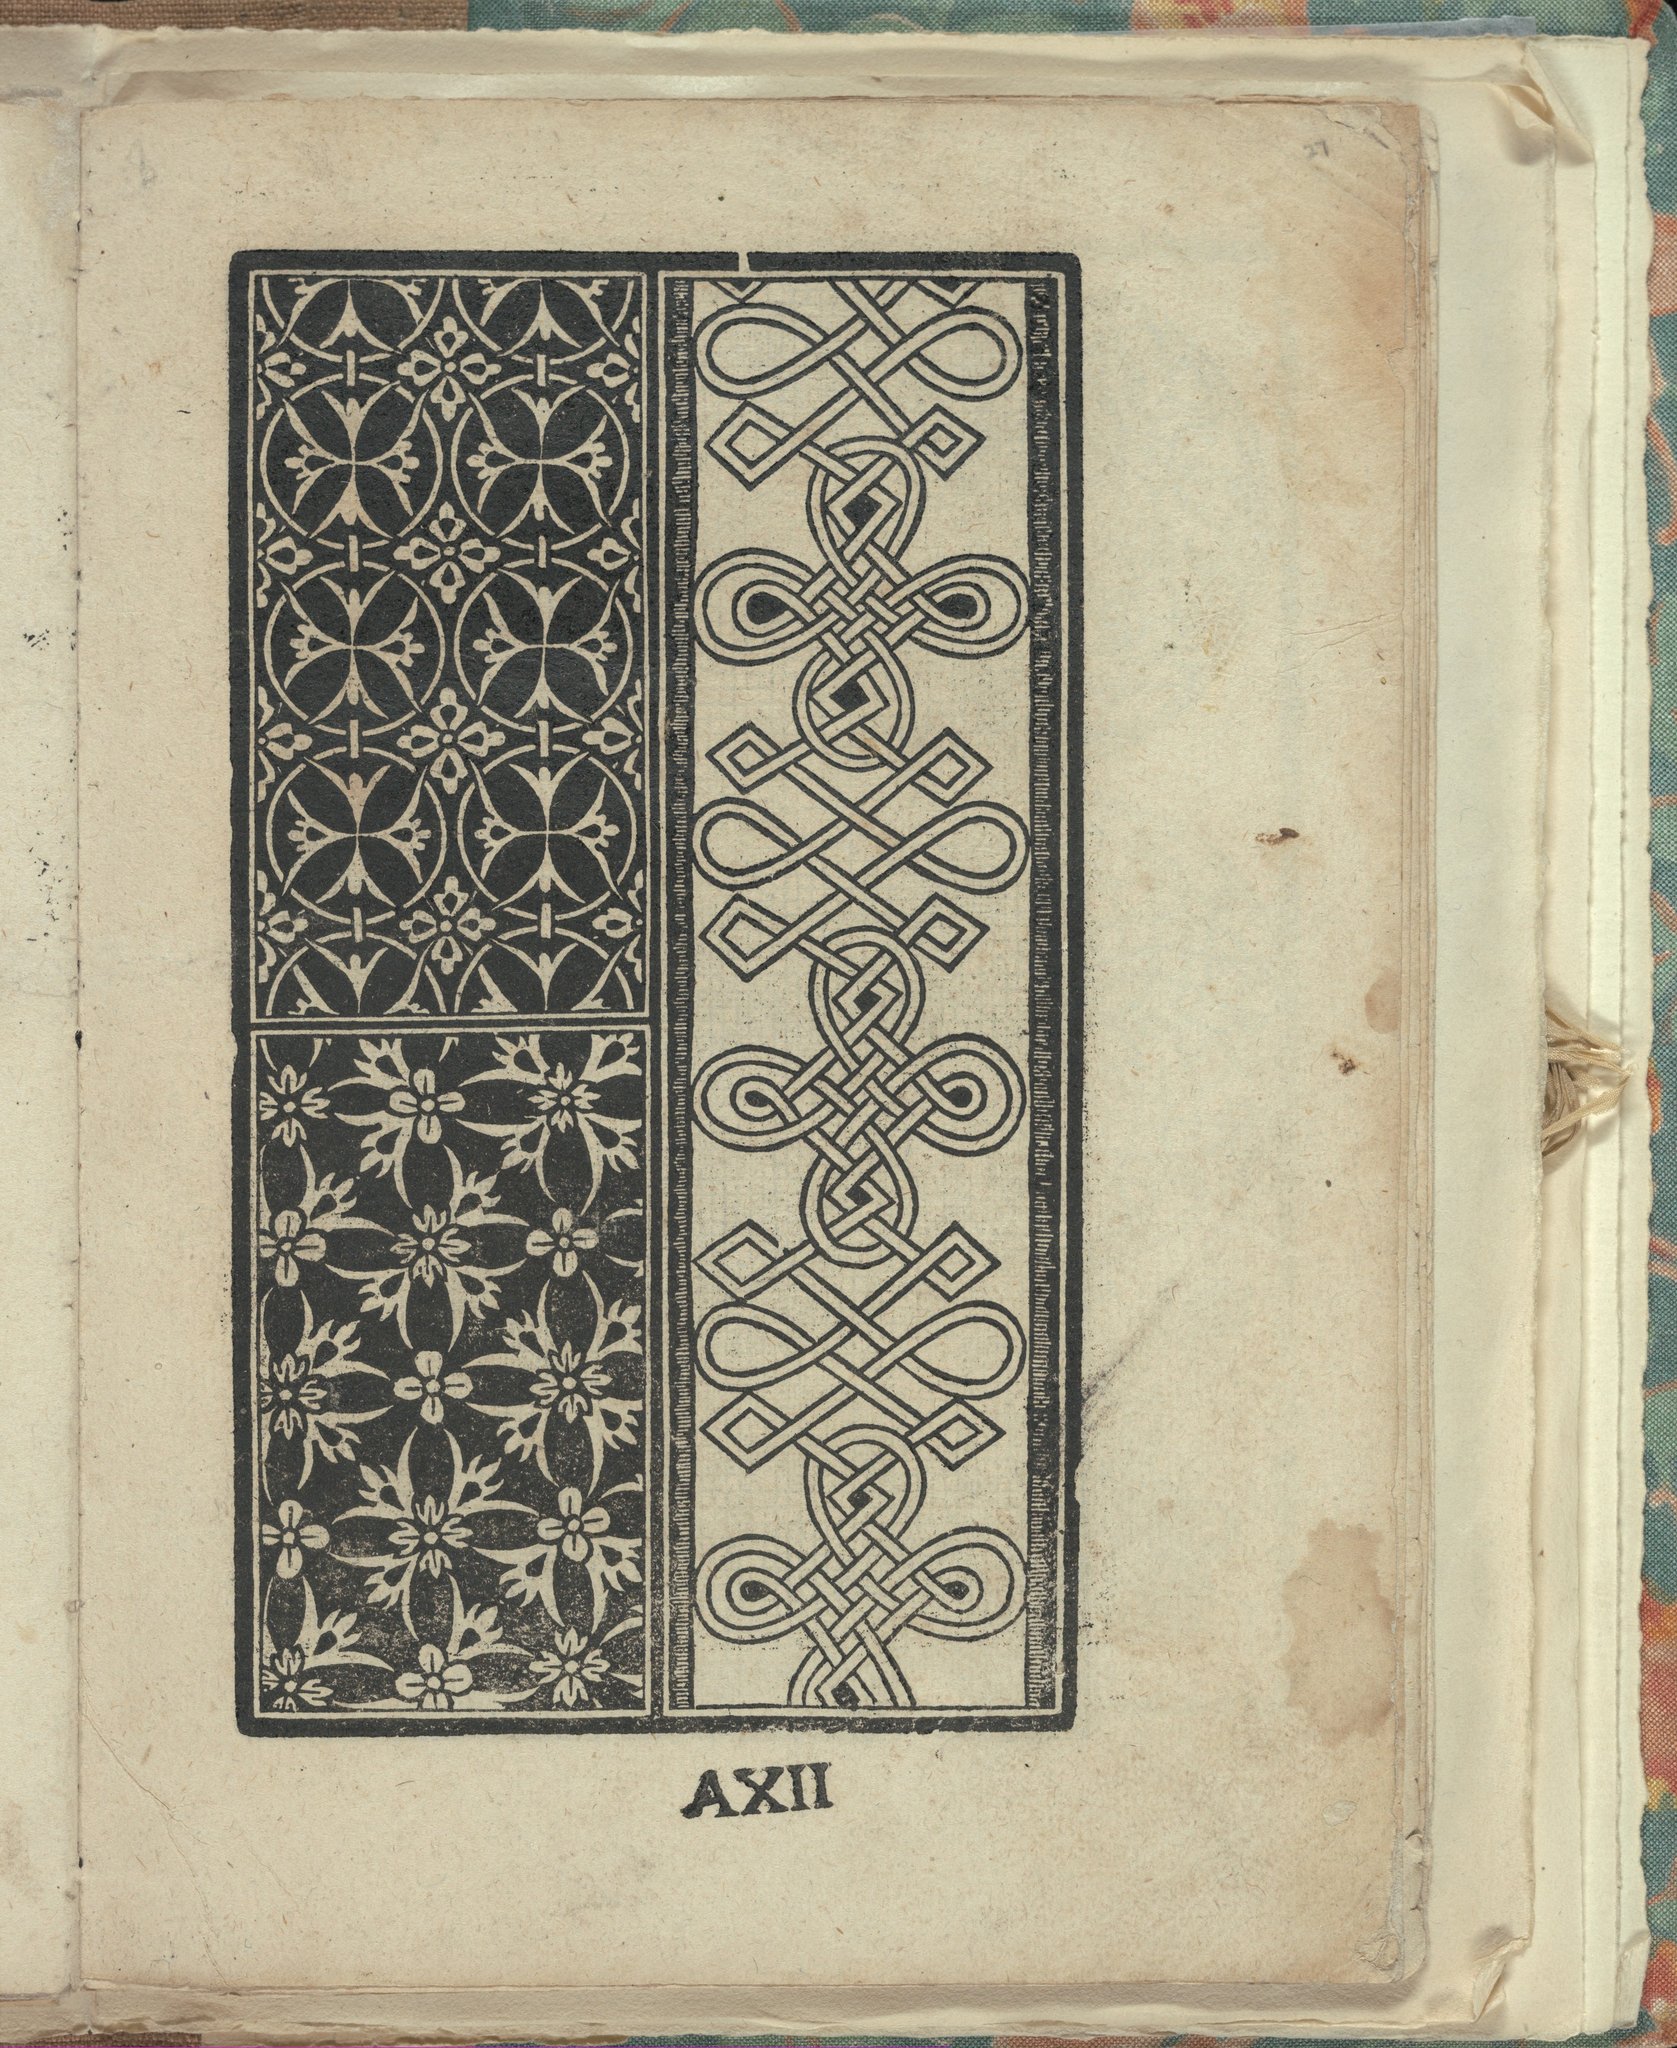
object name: book print ornament architecture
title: Opera Nova Universali intitulata Corona di racammi, page 27 (recto)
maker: giovanni andrea vavassore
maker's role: publisher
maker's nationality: italian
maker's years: 1530-1573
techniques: woodcut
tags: flowers